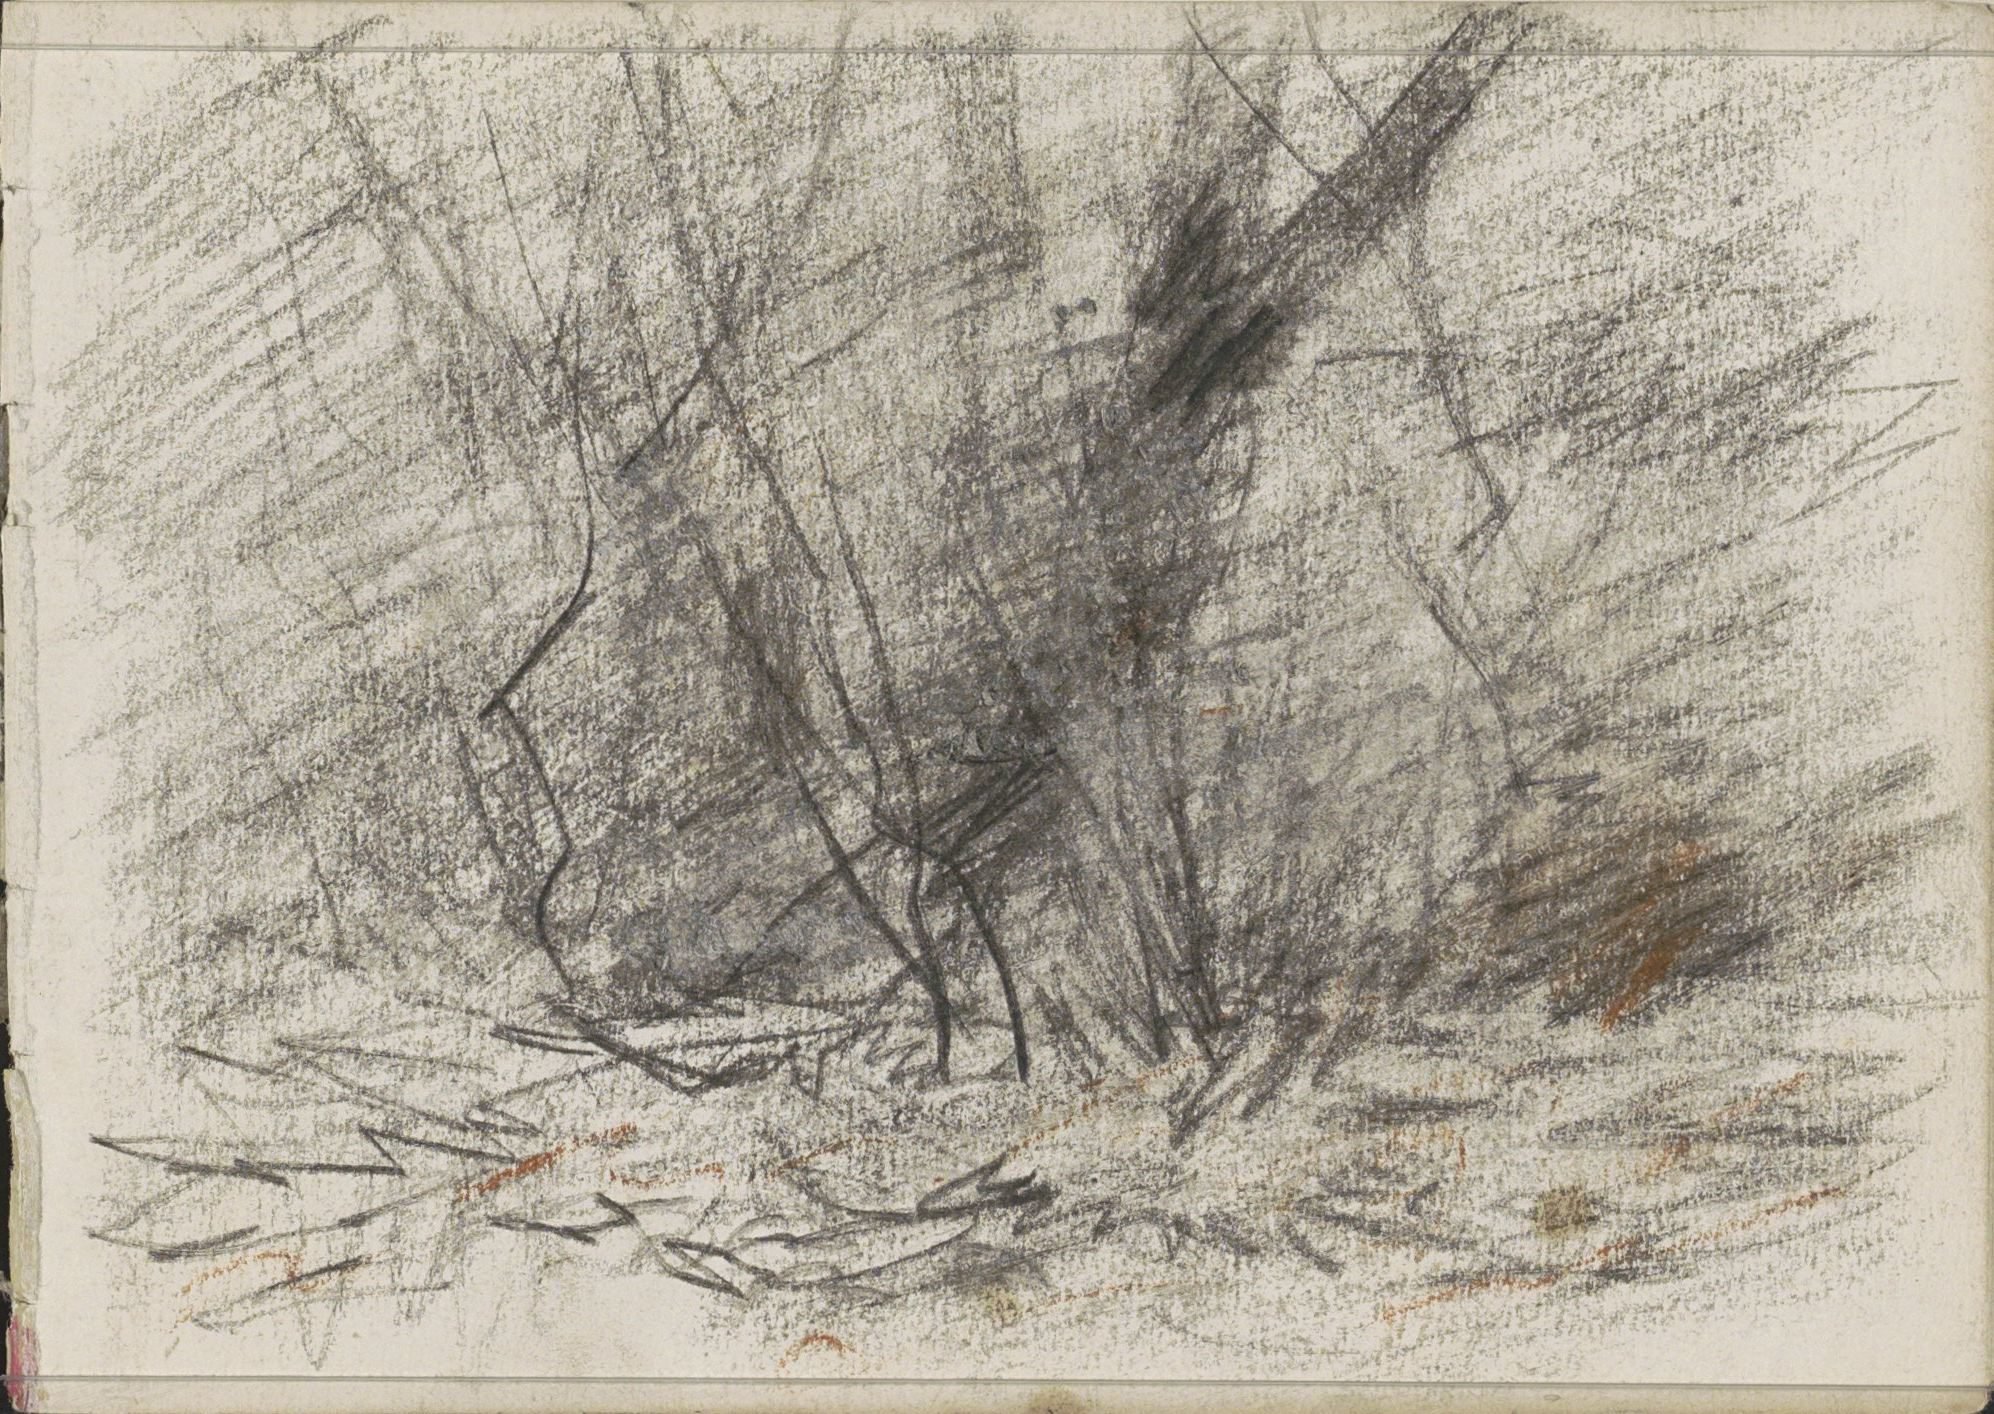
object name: sketchbook leaf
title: Boomstammen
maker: anton mauve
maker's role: draughtsman, painter, print maker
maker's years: 1838-1888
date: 1848-1888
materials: chalk, paper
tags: trees (+ stem, trunk)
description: Blad 8 recto uit een schetsboek met 31 bladen.